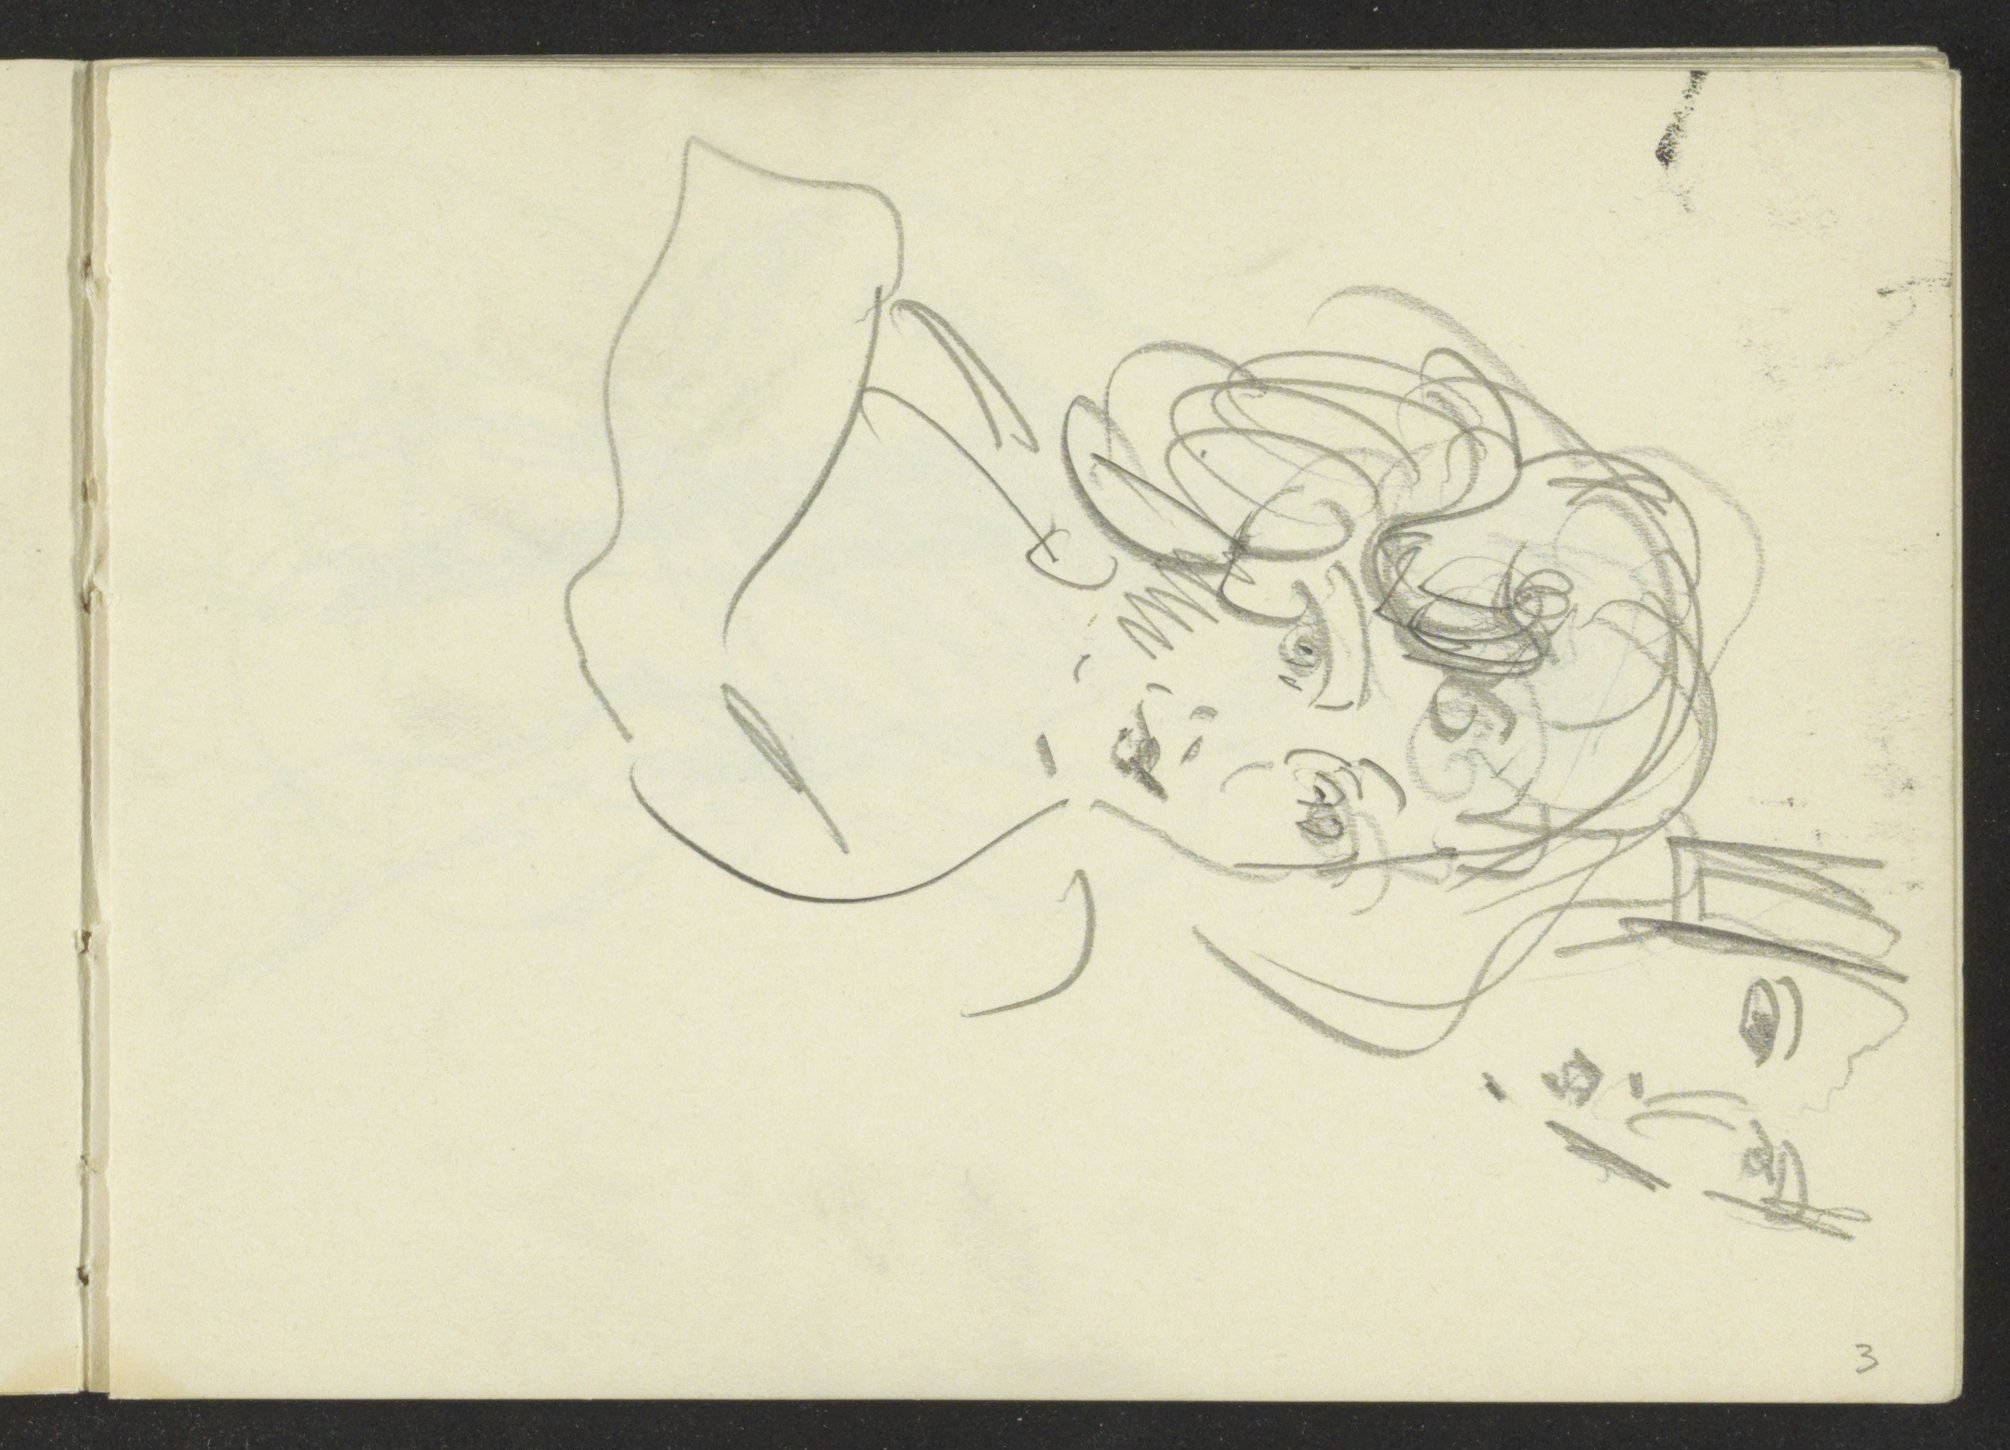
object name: sketchbook leaf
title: Twee vrouwenhoofden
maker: isaac israels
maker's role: draughtsman, painter, print maker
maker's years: 1865-1934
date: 1875-1934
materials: paper, pencil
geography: the hague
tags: head (human) - aa - female human figure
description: Blad 3 recto uit schetsboek LXV met 27 bladen.